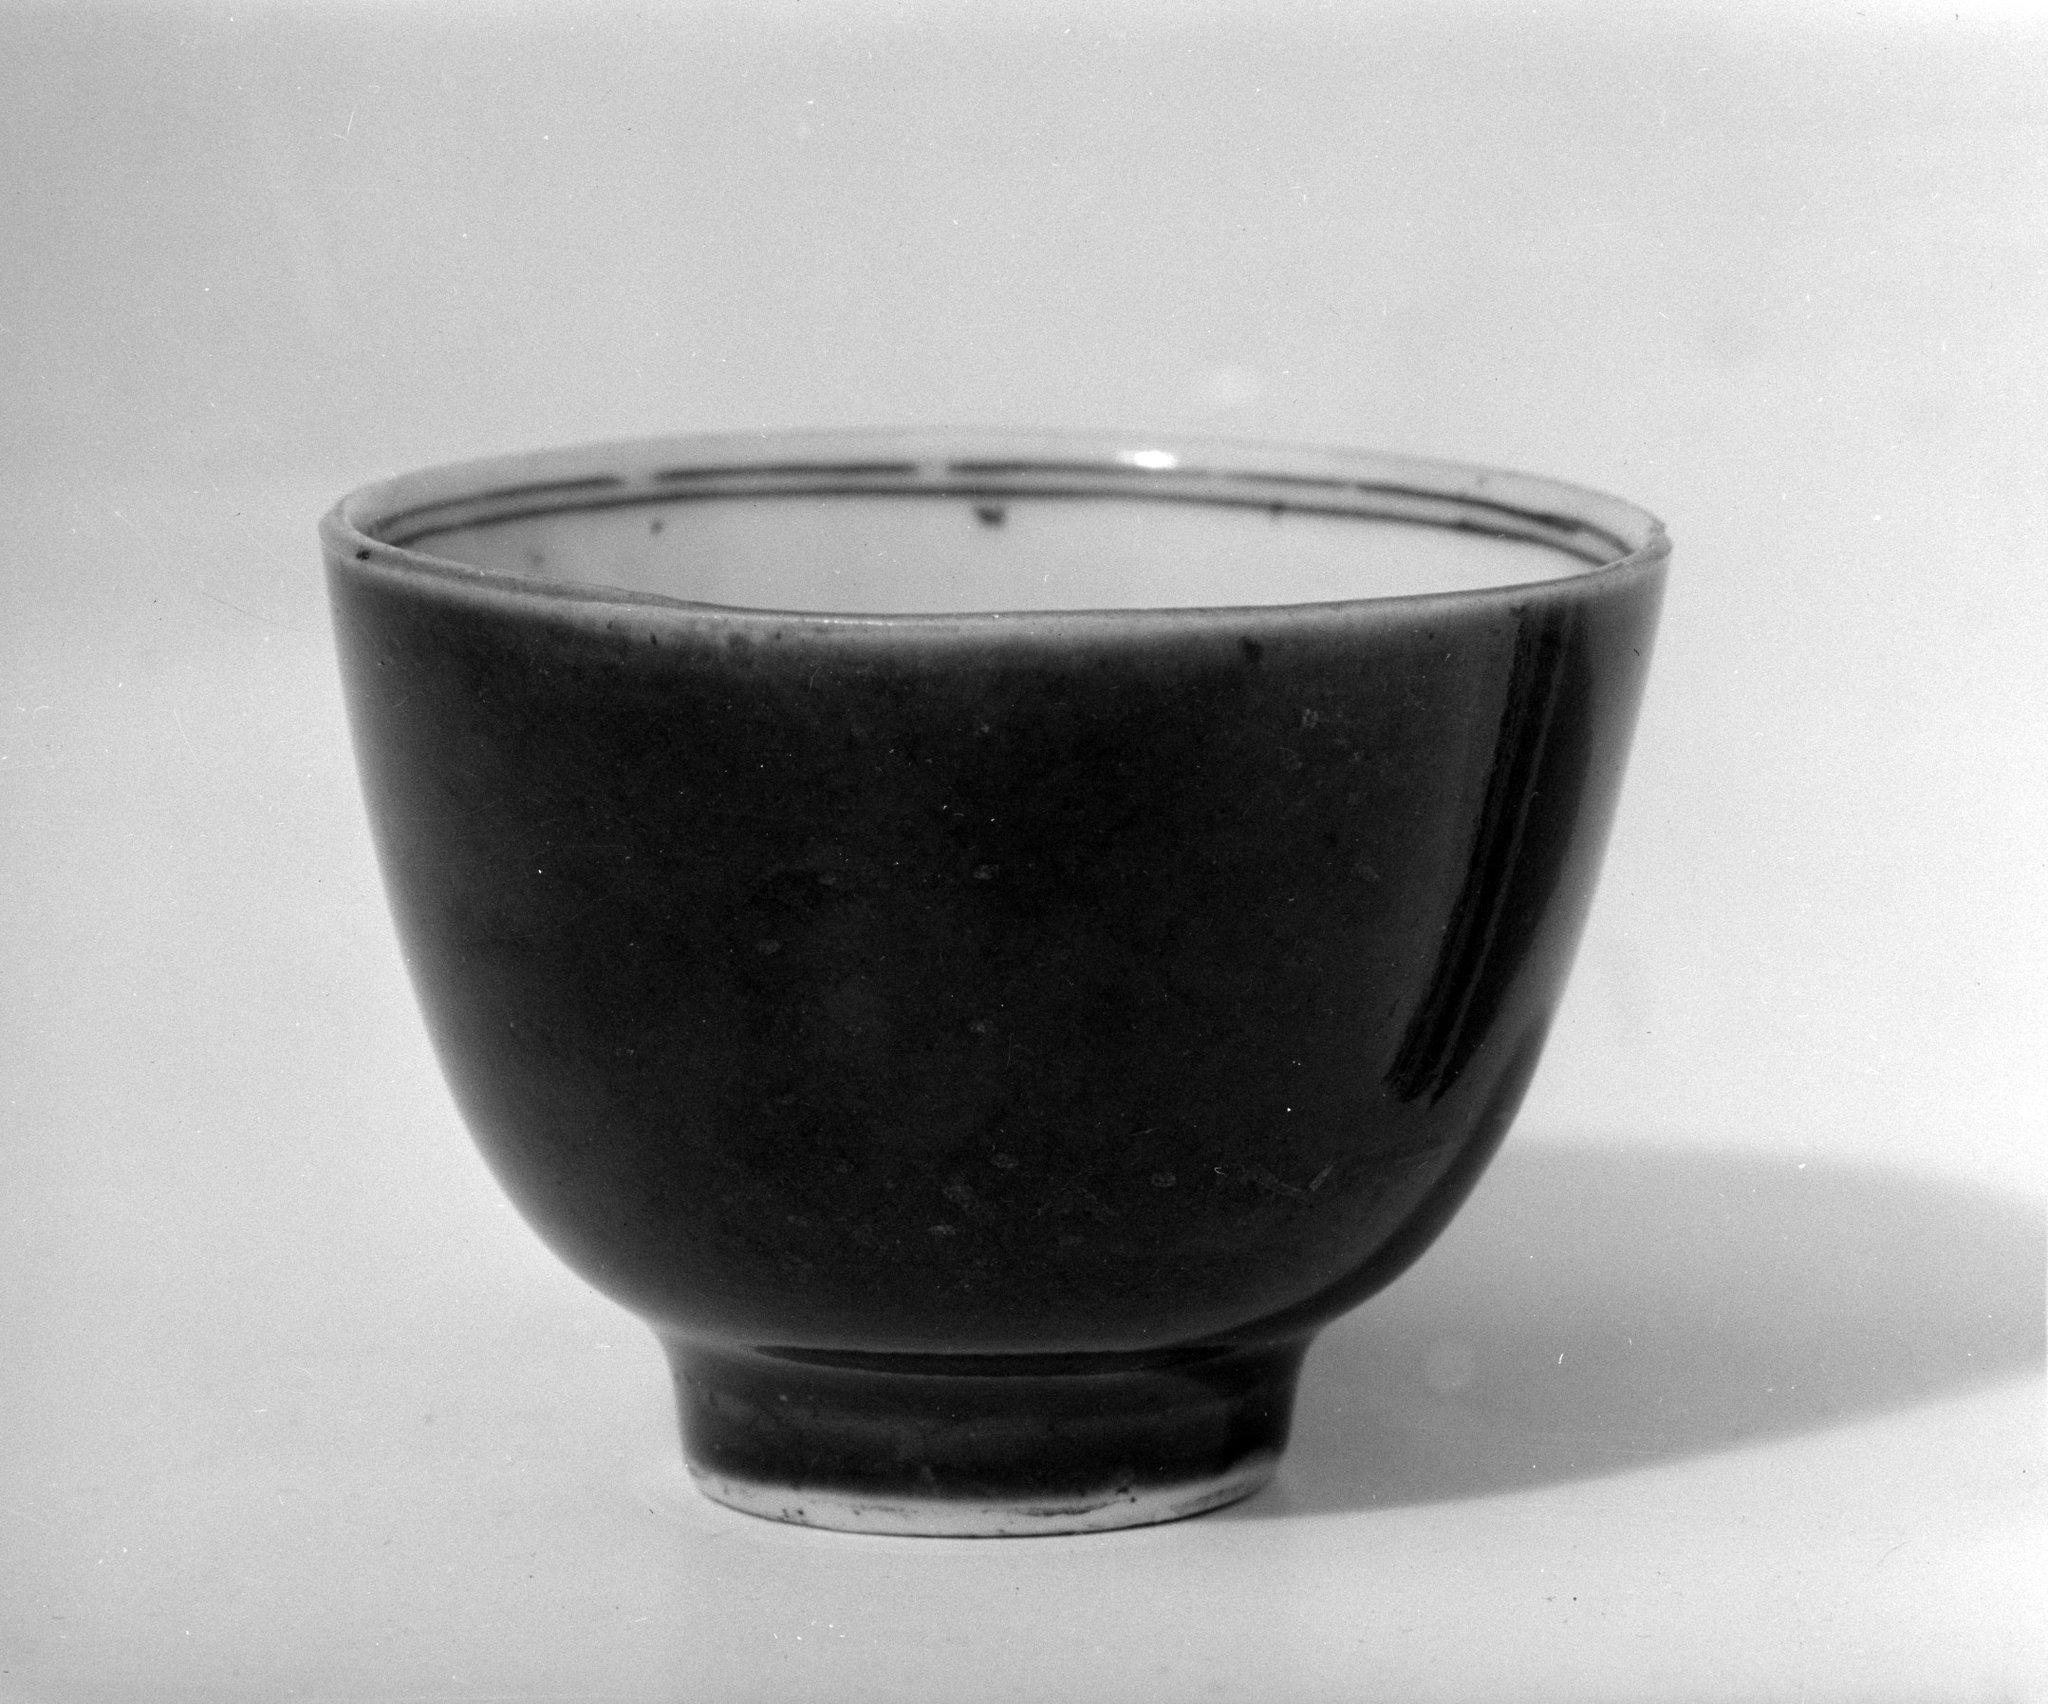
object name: cup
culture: chinese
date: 1736-1795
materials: porcelain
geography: china